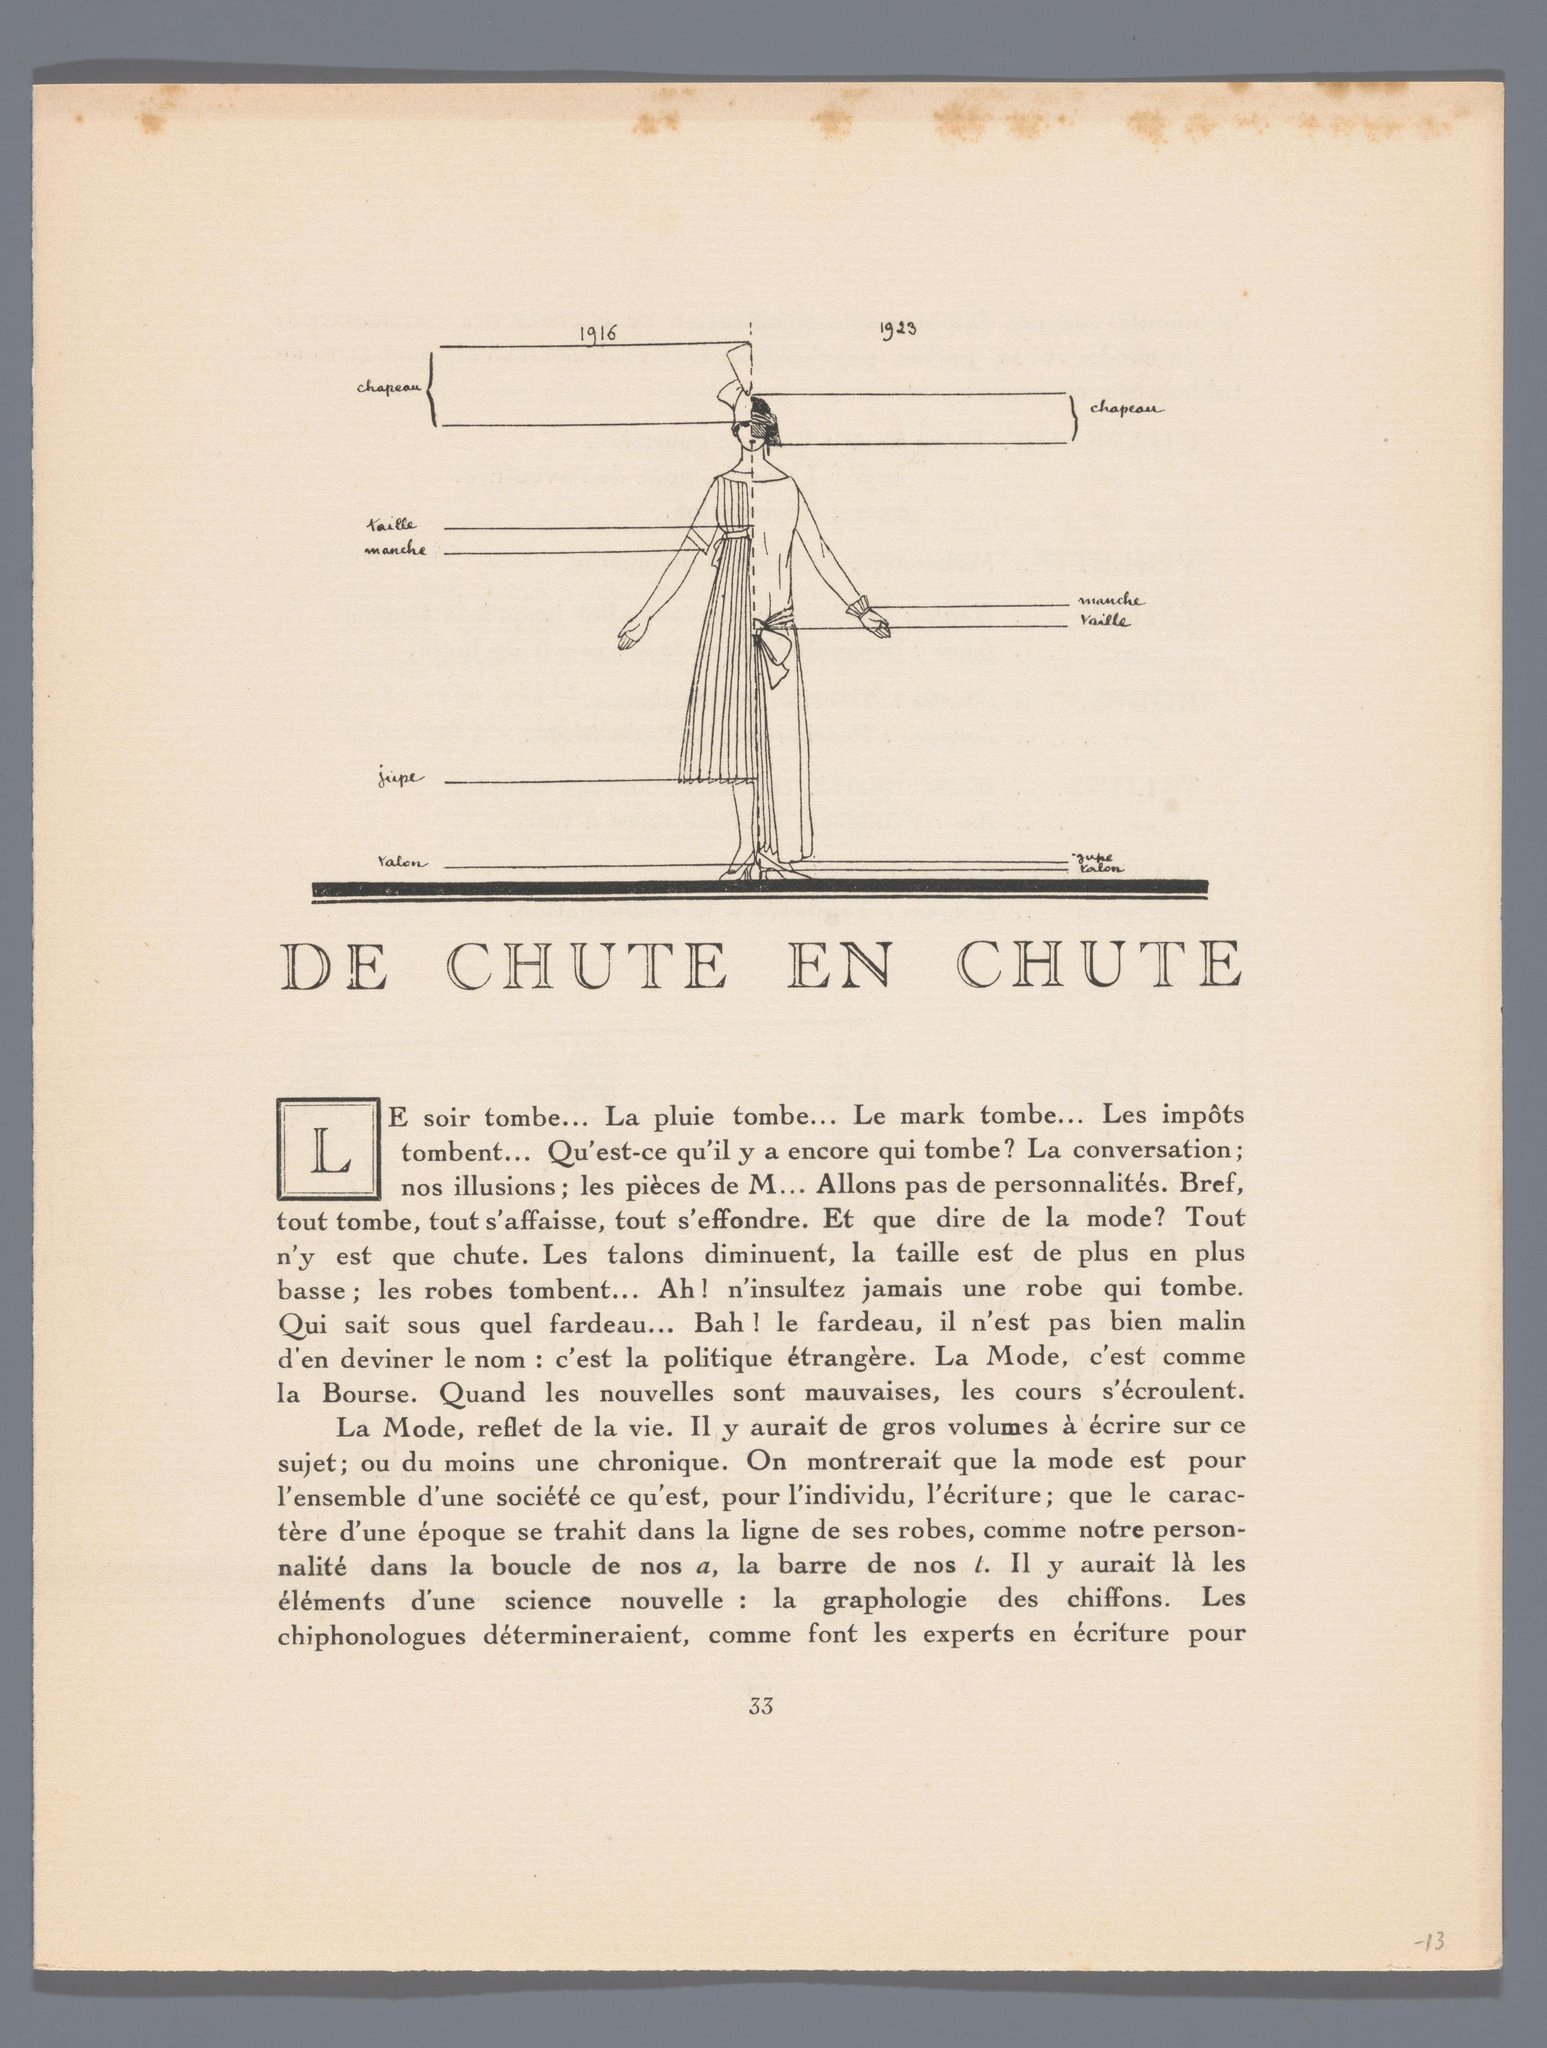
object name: fashion print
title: Gazette du Bon Ton, 1923 - No. 1 : p. 33: De chute en chute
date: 1923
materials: paper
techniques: letterpress printing, photochemical processes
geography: paris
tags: fashion plates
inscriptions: date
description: De chute en chute: Tekst en illustratie over het verloop van de modes van 1914 tot en met 1922: de hoogte van de taille, de lengte van de rokken en de vorm van de hoeden. Gazette du Bon Ton, 1923 - No. 1 : p. 33